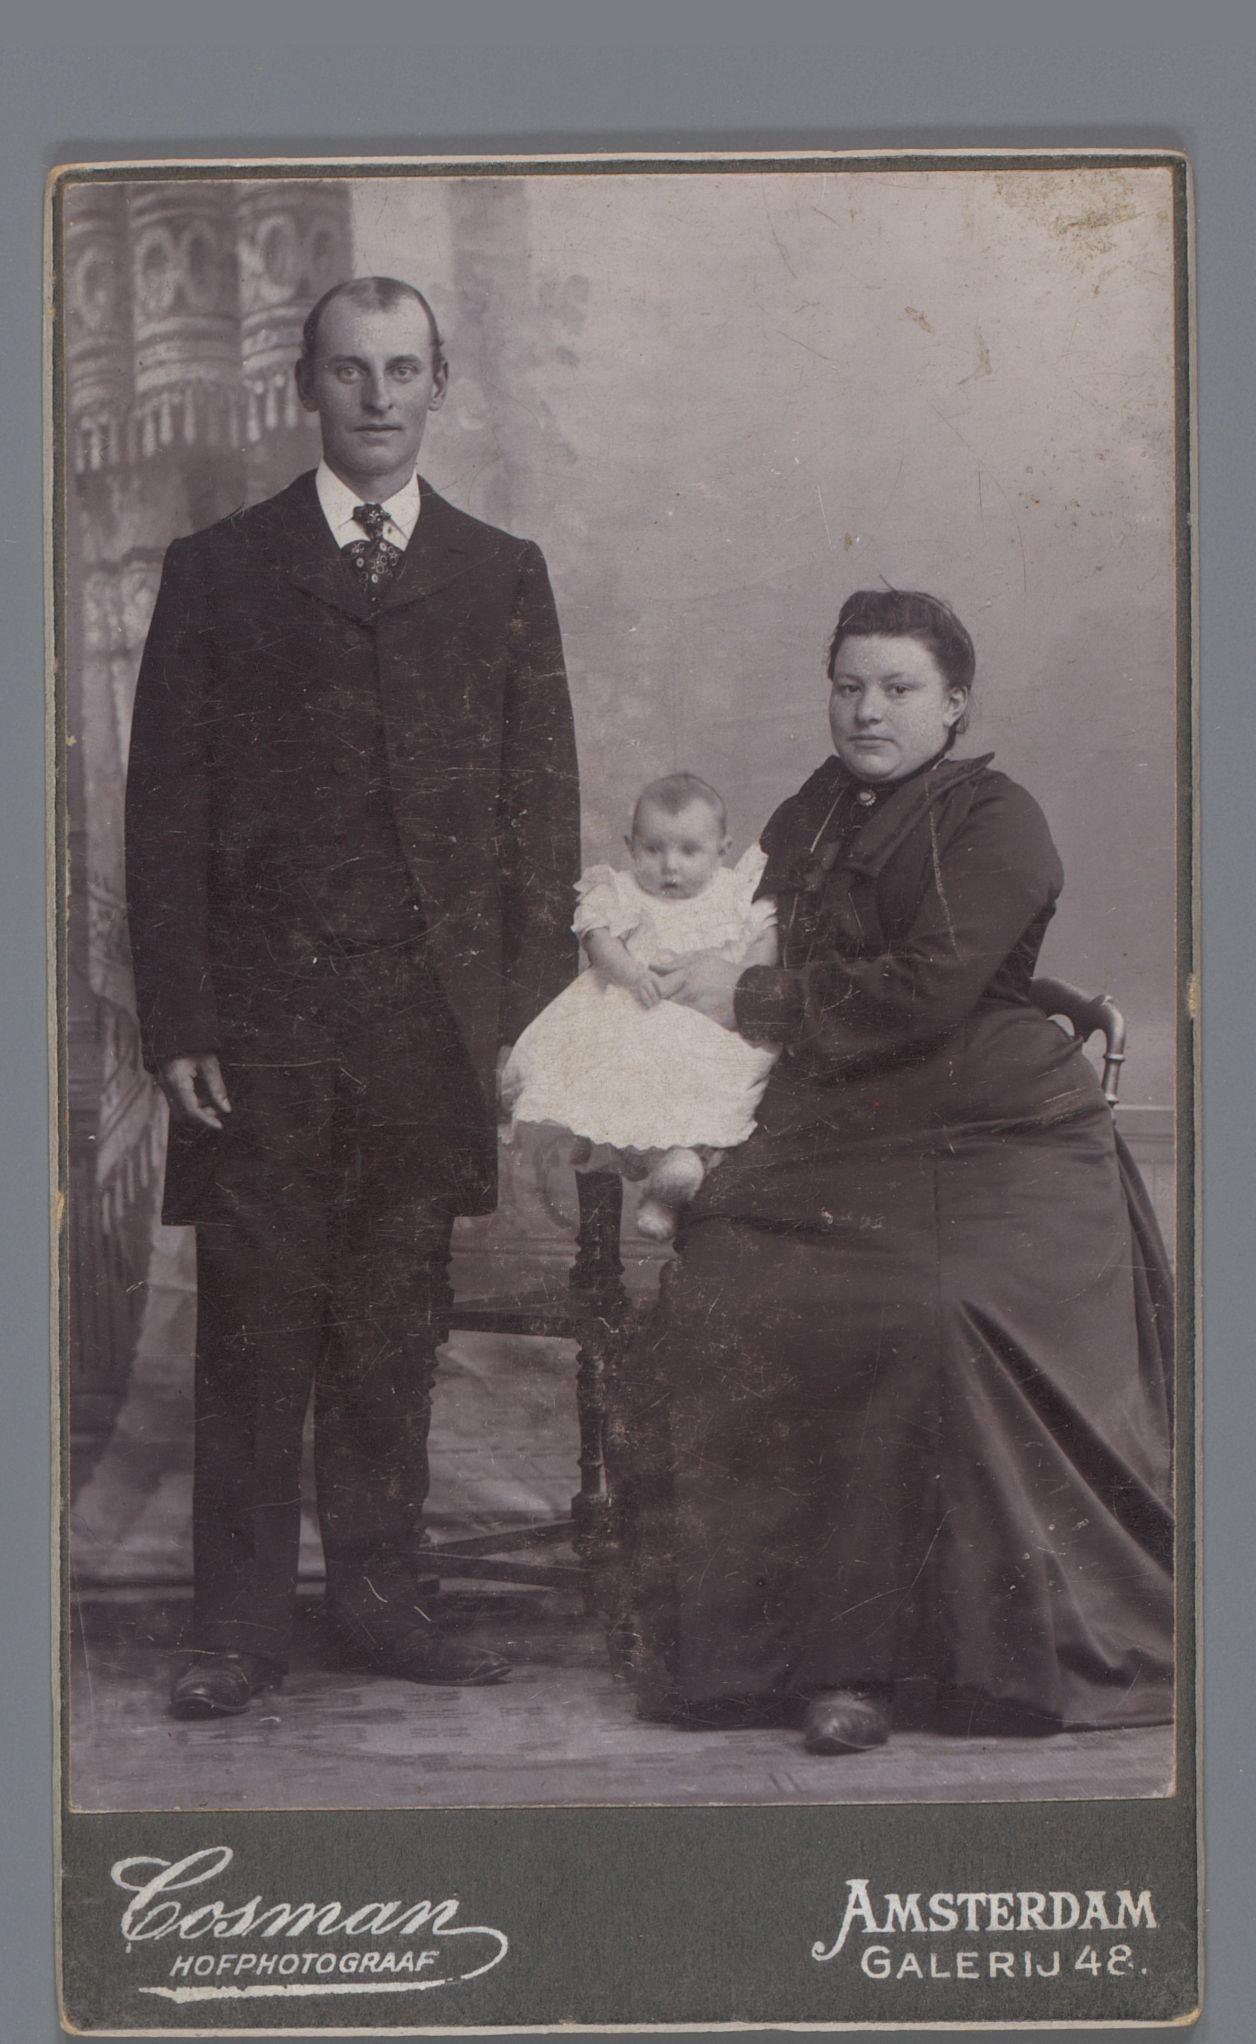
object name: photograph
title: Groepsportret van een onbekende man, vrouw en kind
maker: max cosman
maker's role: fotograaf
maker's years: 1852-1894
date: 1881-1903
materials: paper, cardboard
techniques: gelatin silver print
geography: amsterdam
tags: family, relationship, descent, anonymous historical persons portrayed in a group, in a group-portrait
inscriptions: address: ‘Amsterdam/ Galerij 48.’